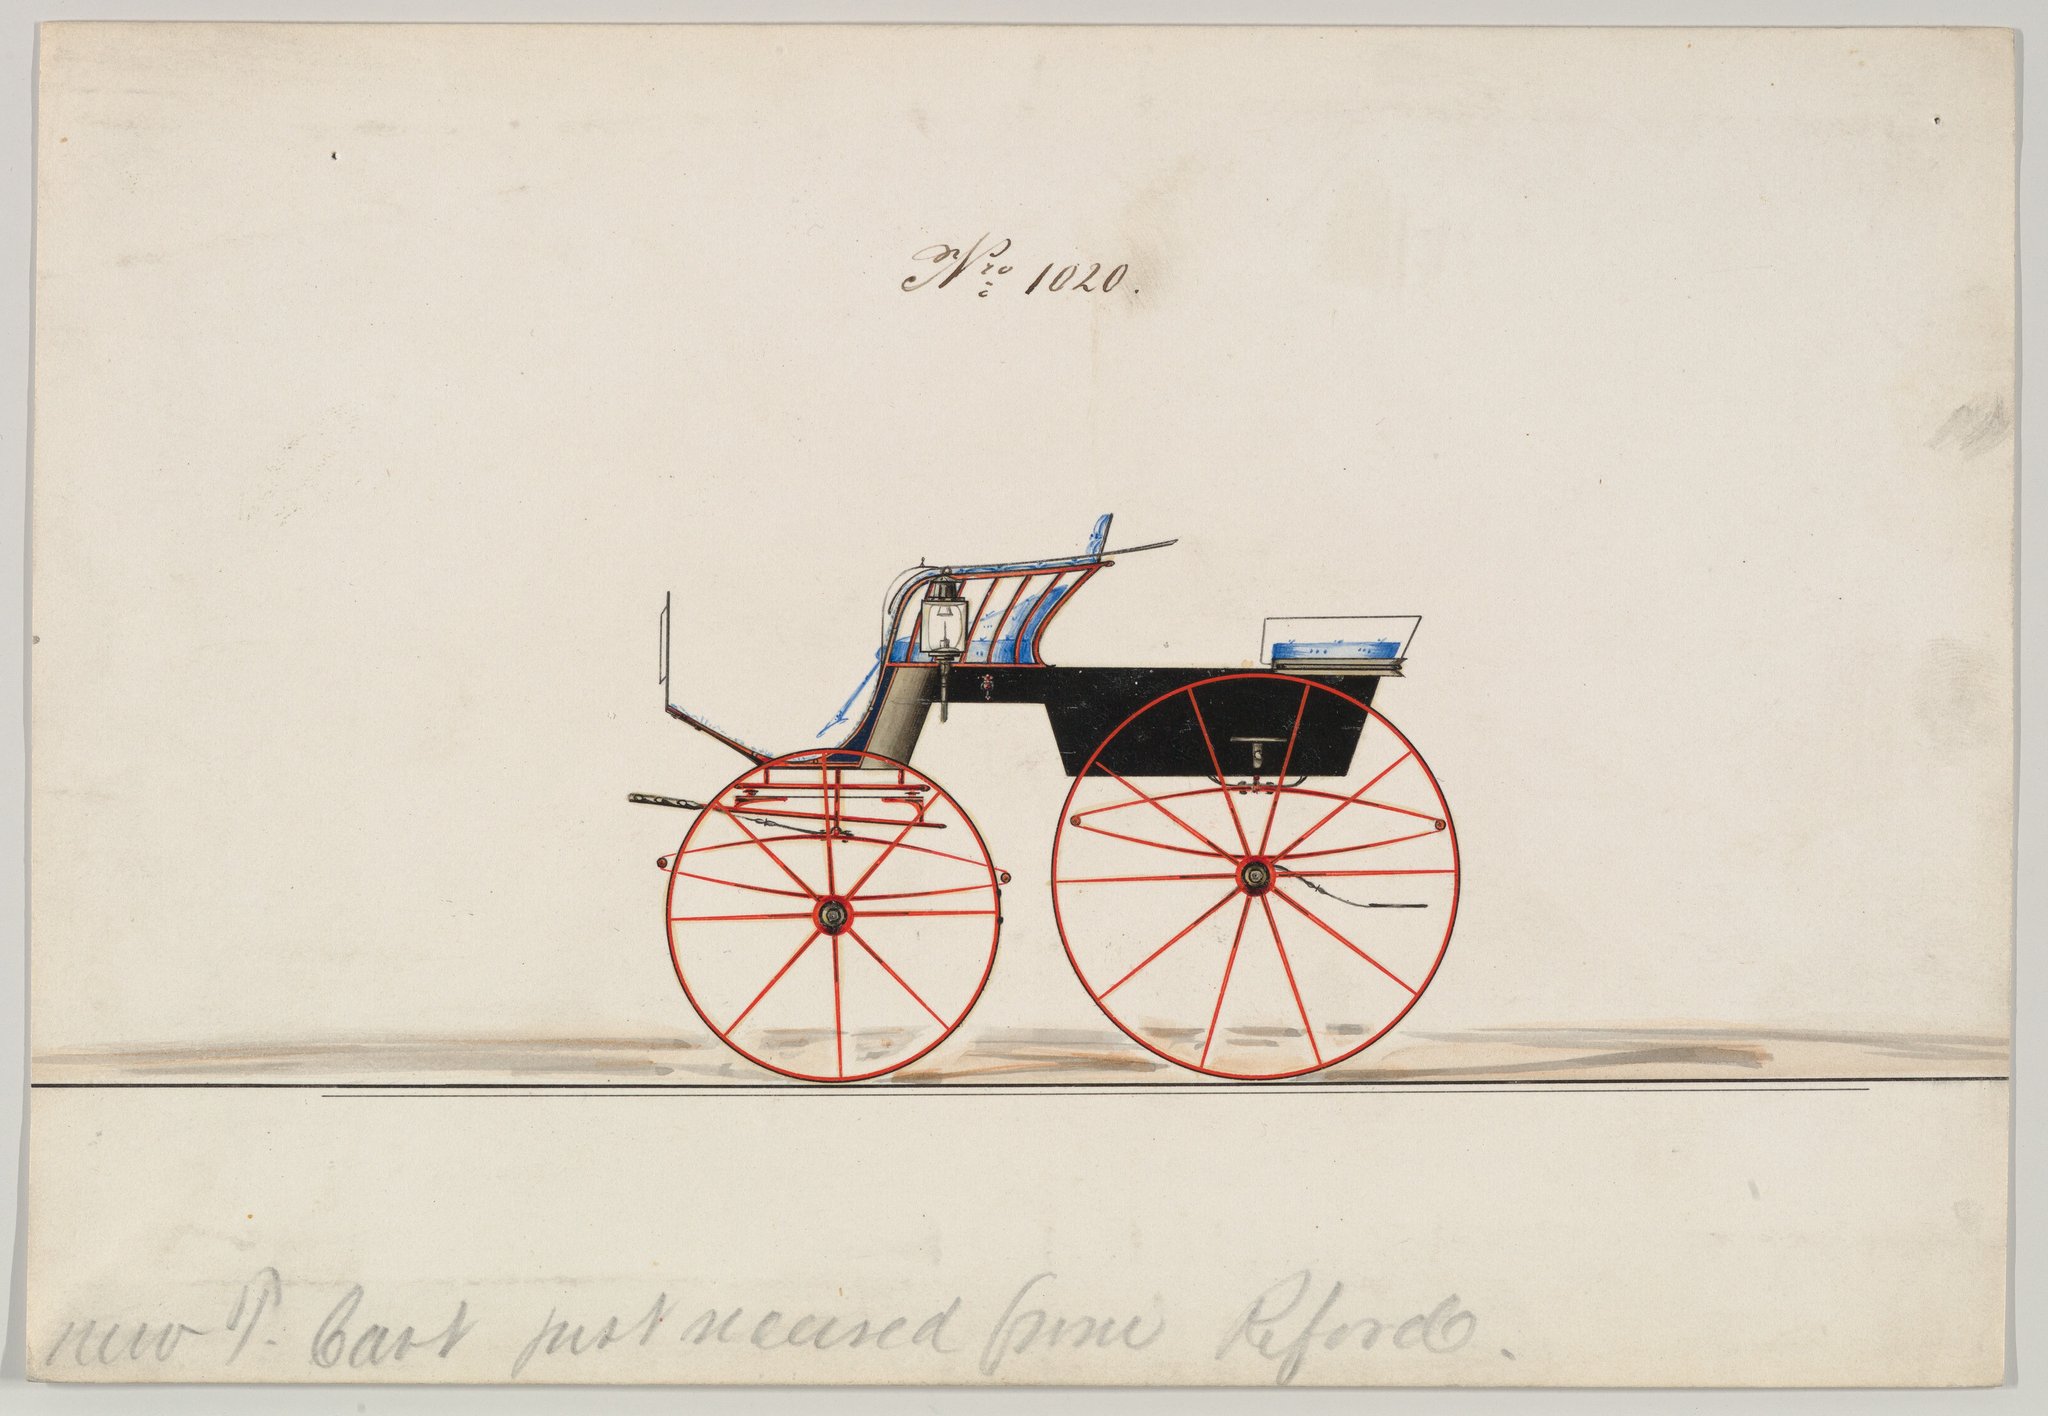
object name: drawing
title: T-Cart Phaeton #1020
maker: brewster & co.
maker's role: manufacturer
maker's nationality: american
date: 1850-1870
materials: ink, watercolor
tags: carriages